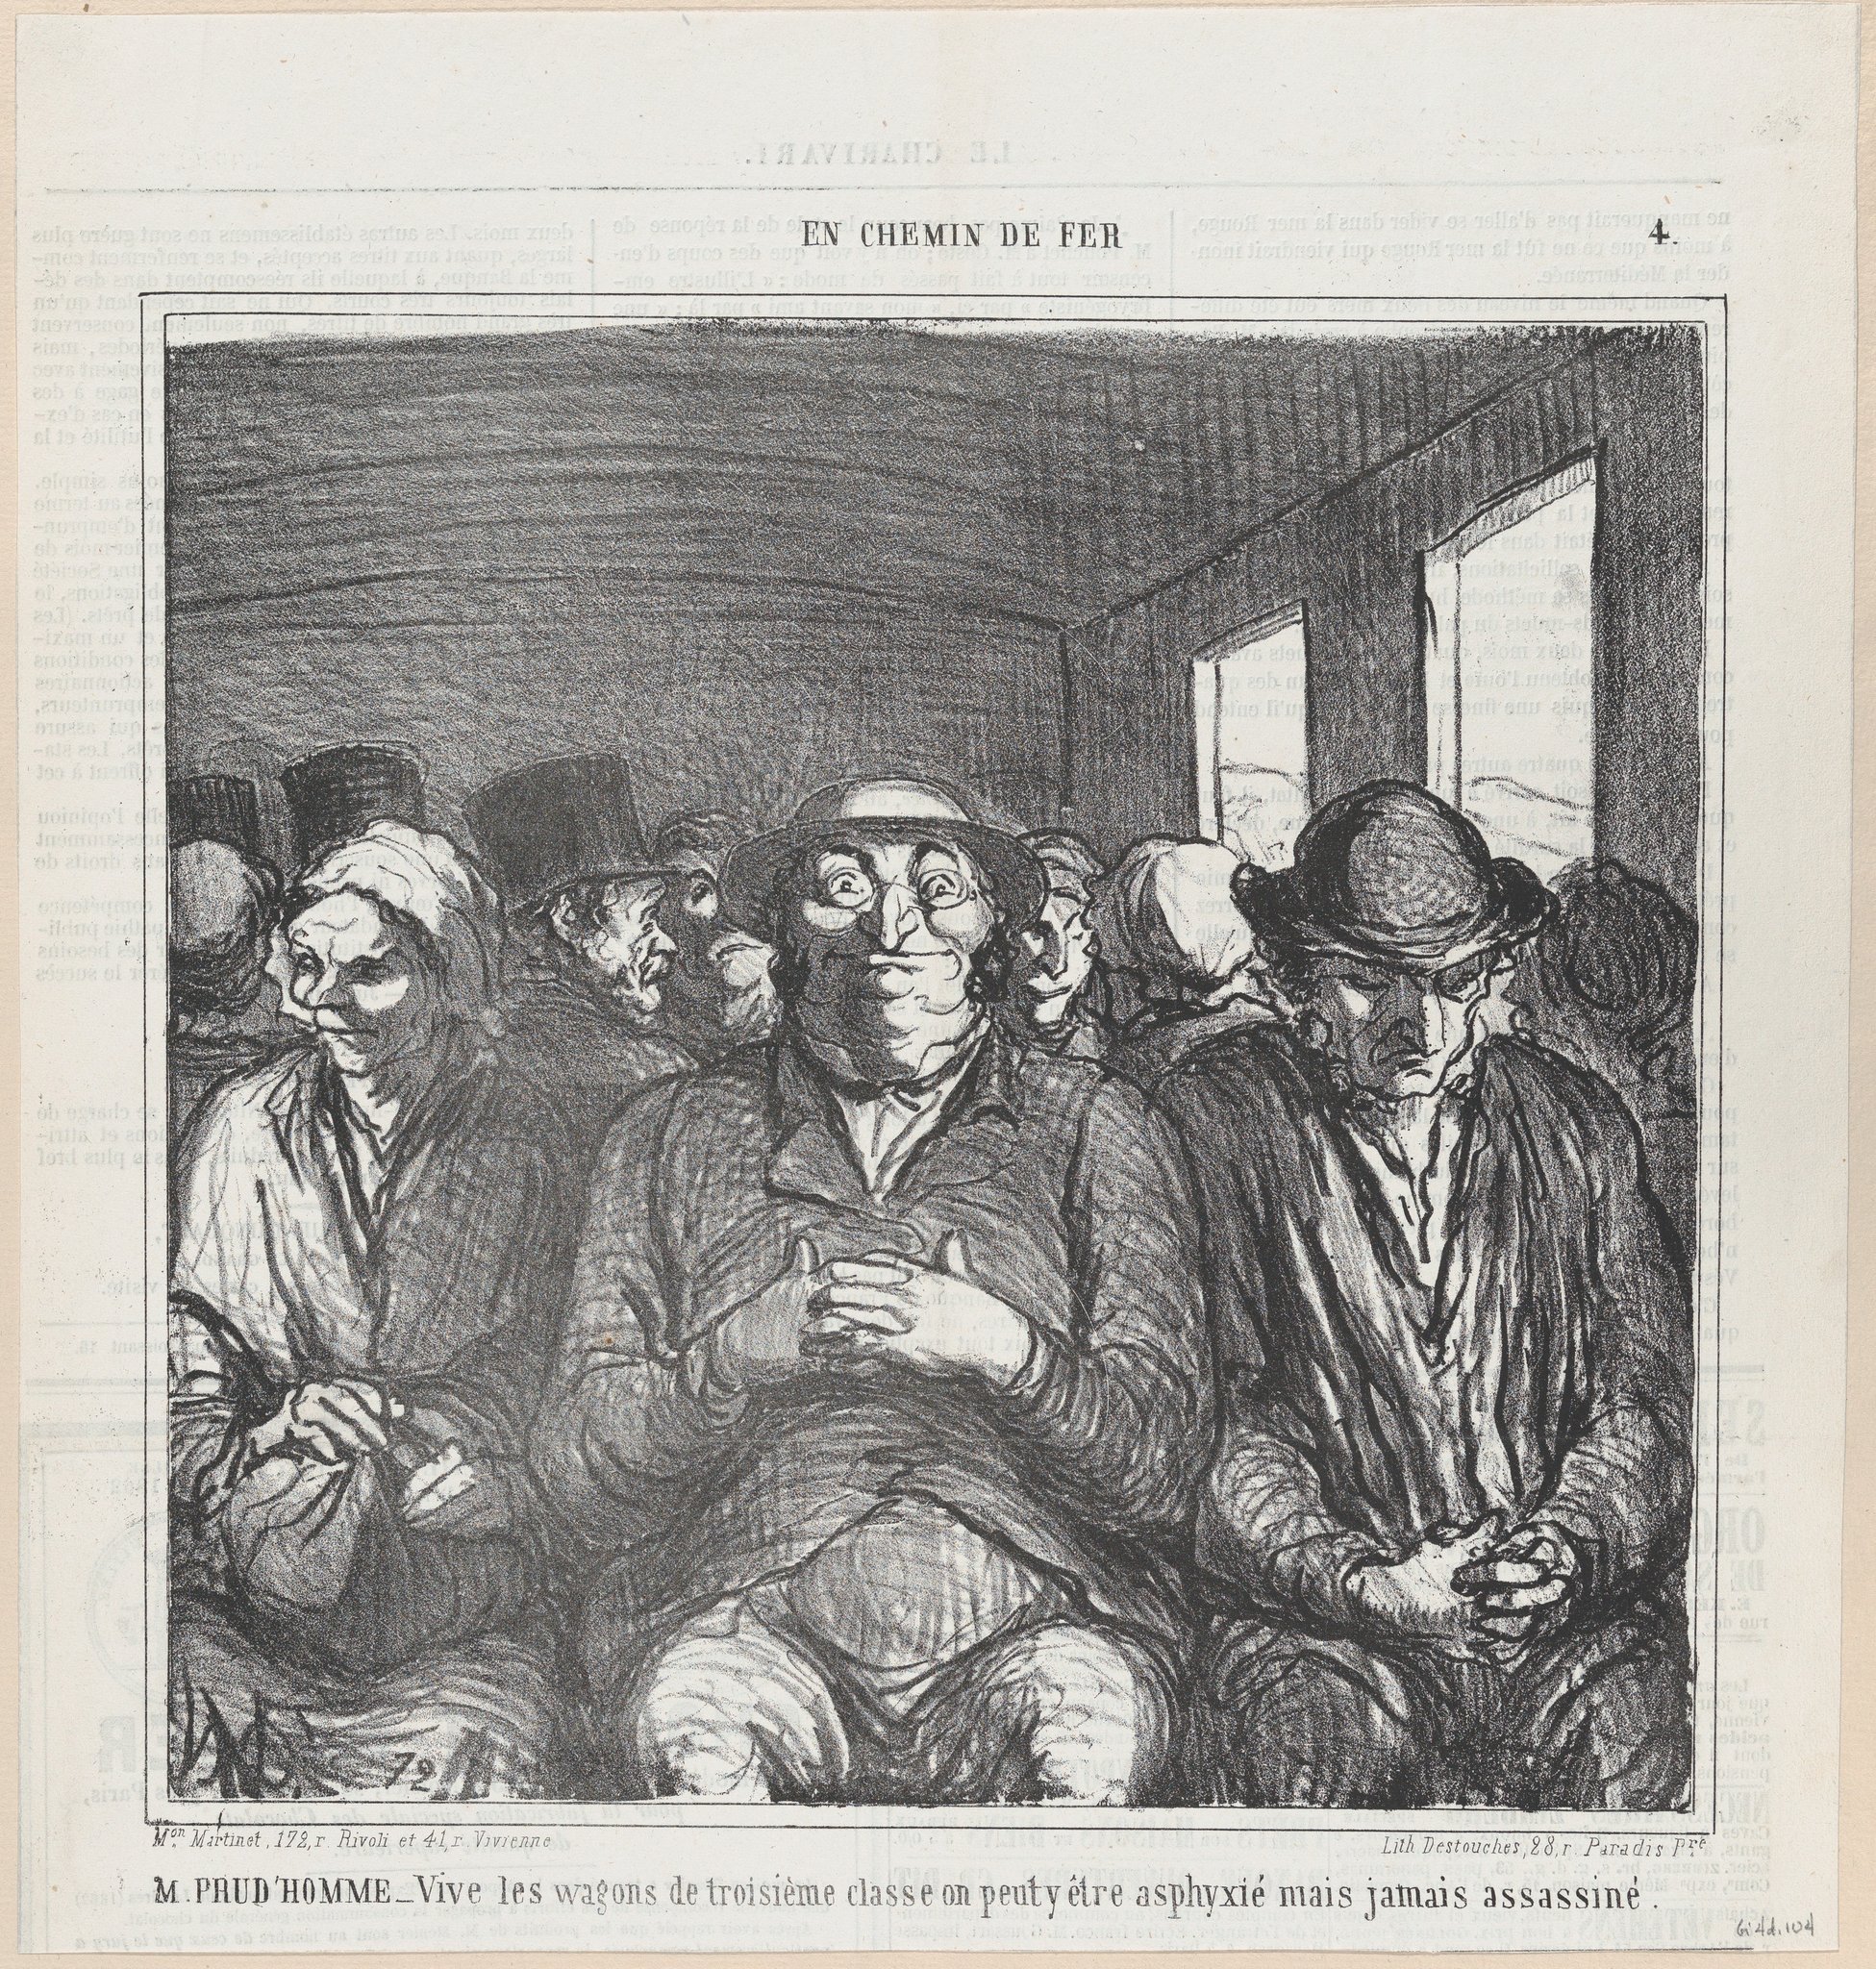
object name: print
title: Mr. PRUDHOMME: Long live the third class compartments..., from 'On the train,' published in Le Charivari, August 30, 1864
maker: honoré daumier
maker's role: artist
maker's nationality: french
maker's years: 1808-1879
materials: paper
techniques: lithograph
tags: satire,men,trains